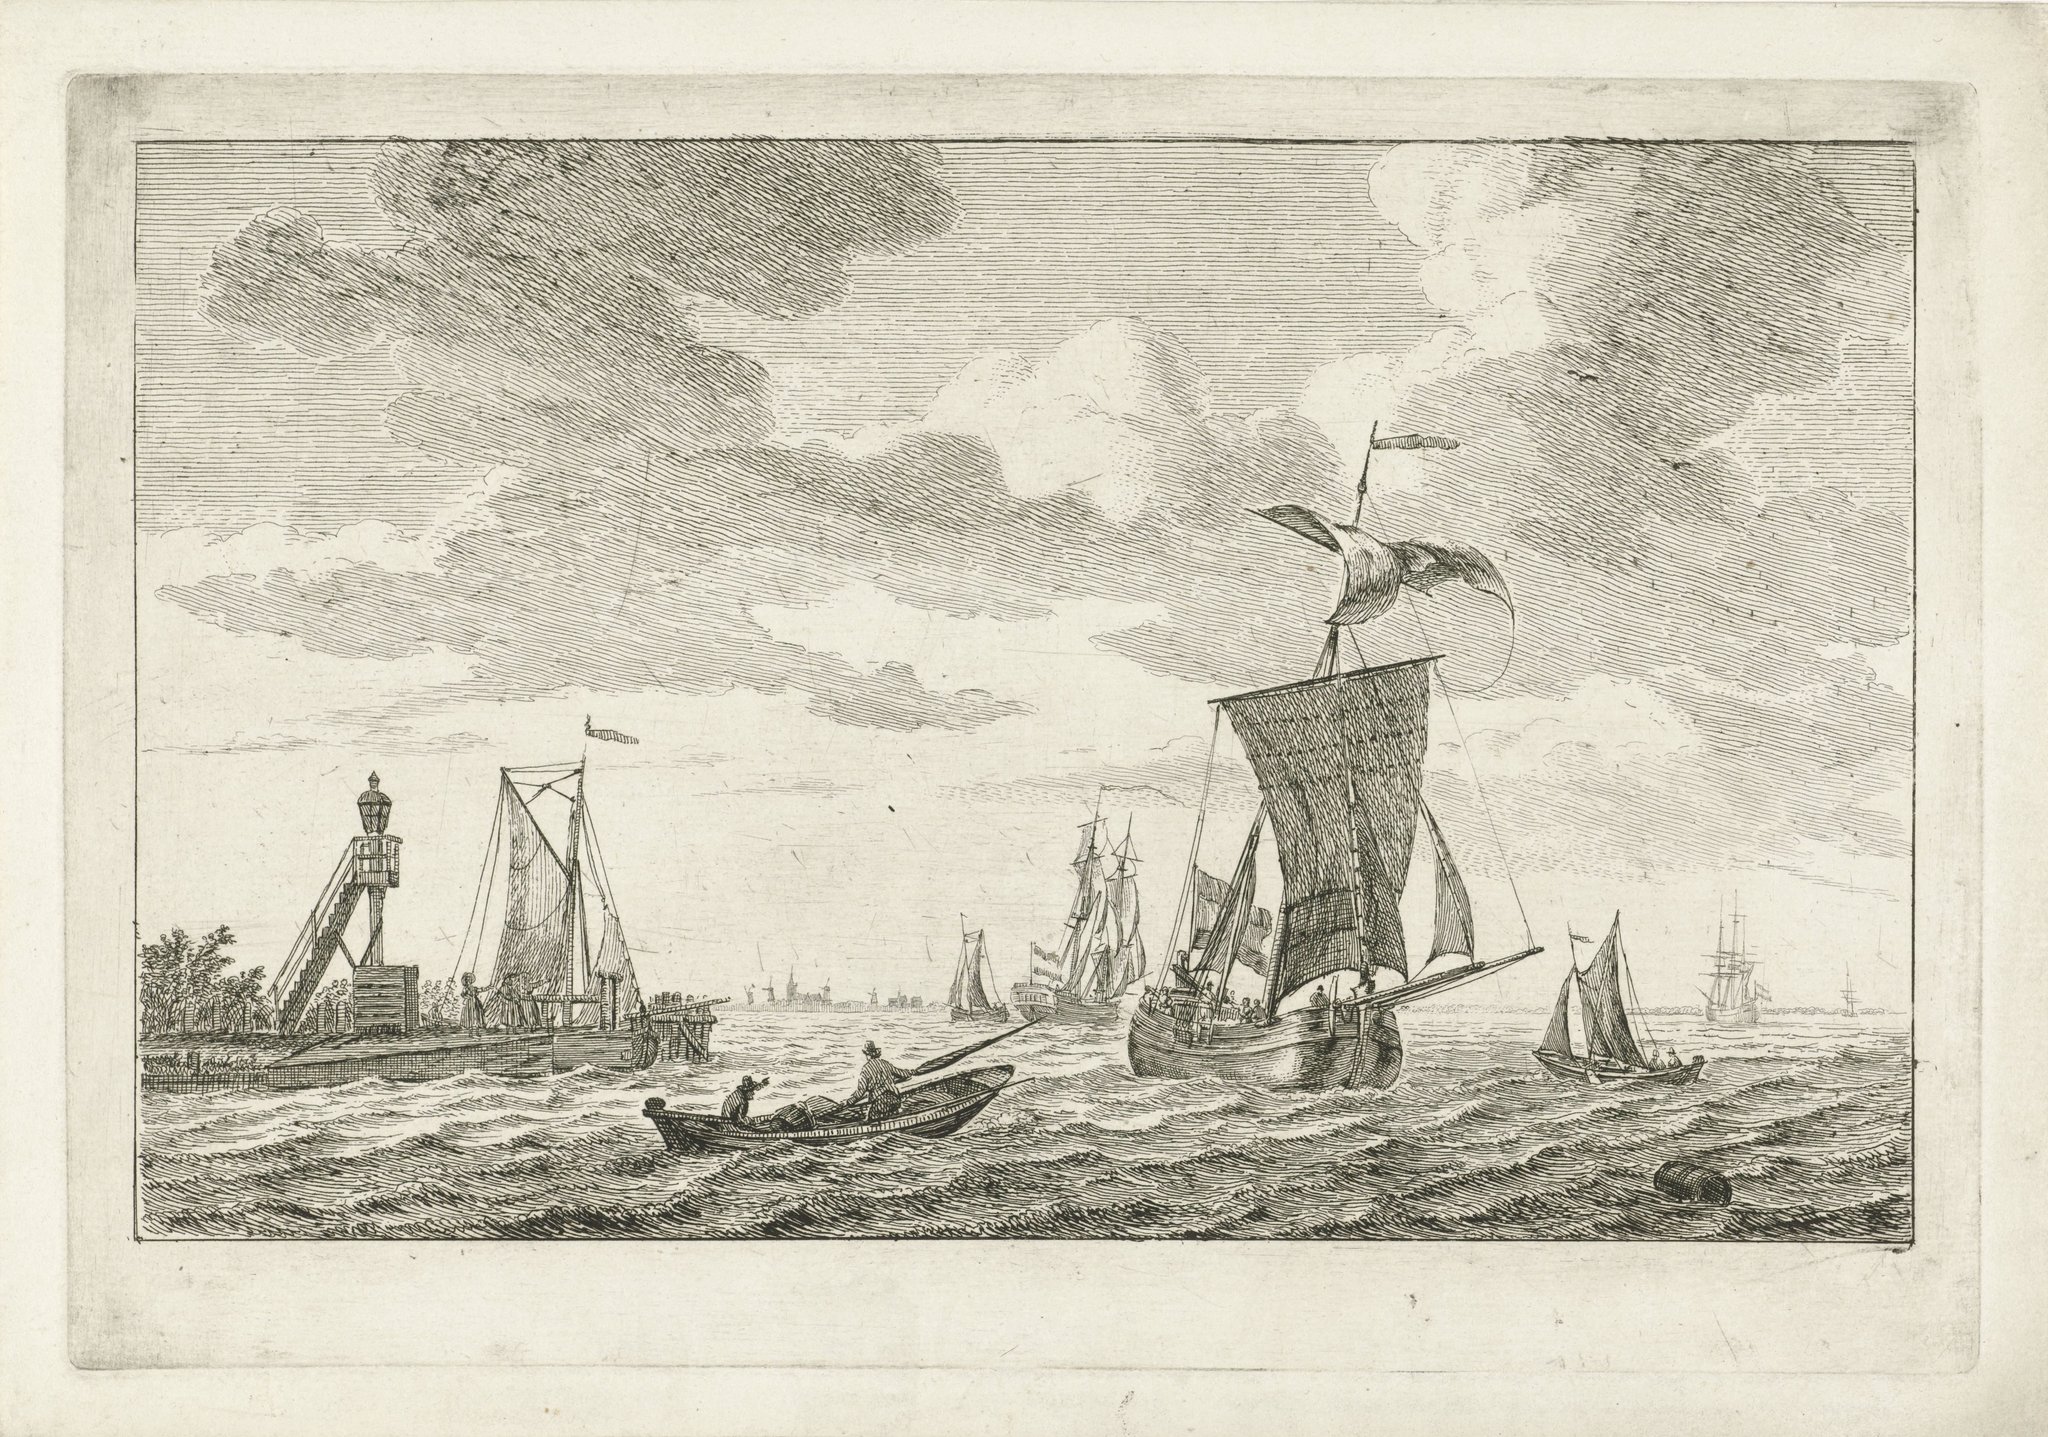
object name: print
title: Gezichten op de Maas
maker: gerrit groenewegen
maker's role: draughtsman, print maker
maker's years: 1754-1826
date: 1797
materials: paper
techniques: etching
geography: rotterdam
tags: harbour, sailing-ship, sailing-boat, rowing-boat, canoe, etc.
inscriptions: collector's mark: Lugt 2228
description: Gezicht op de Maas en het havenhoofd van Vlaardingen (links). In het water een roeiboot en een aantal zeilschepen. Links op de achtergrond de contouren van Schiedam, rechts de zuidelijke Maasoever. Deze prent maakt deel uit van een serie van zes prenten met Maasgezichten.